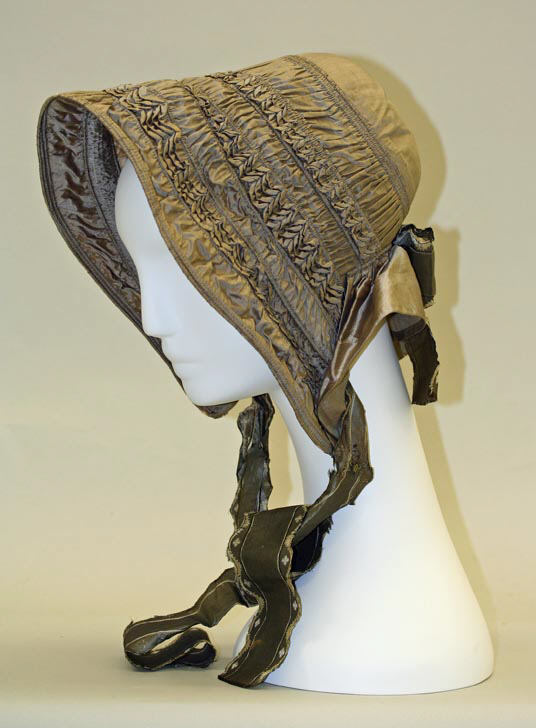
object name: bonnet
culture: american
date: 1851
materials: silk, metal